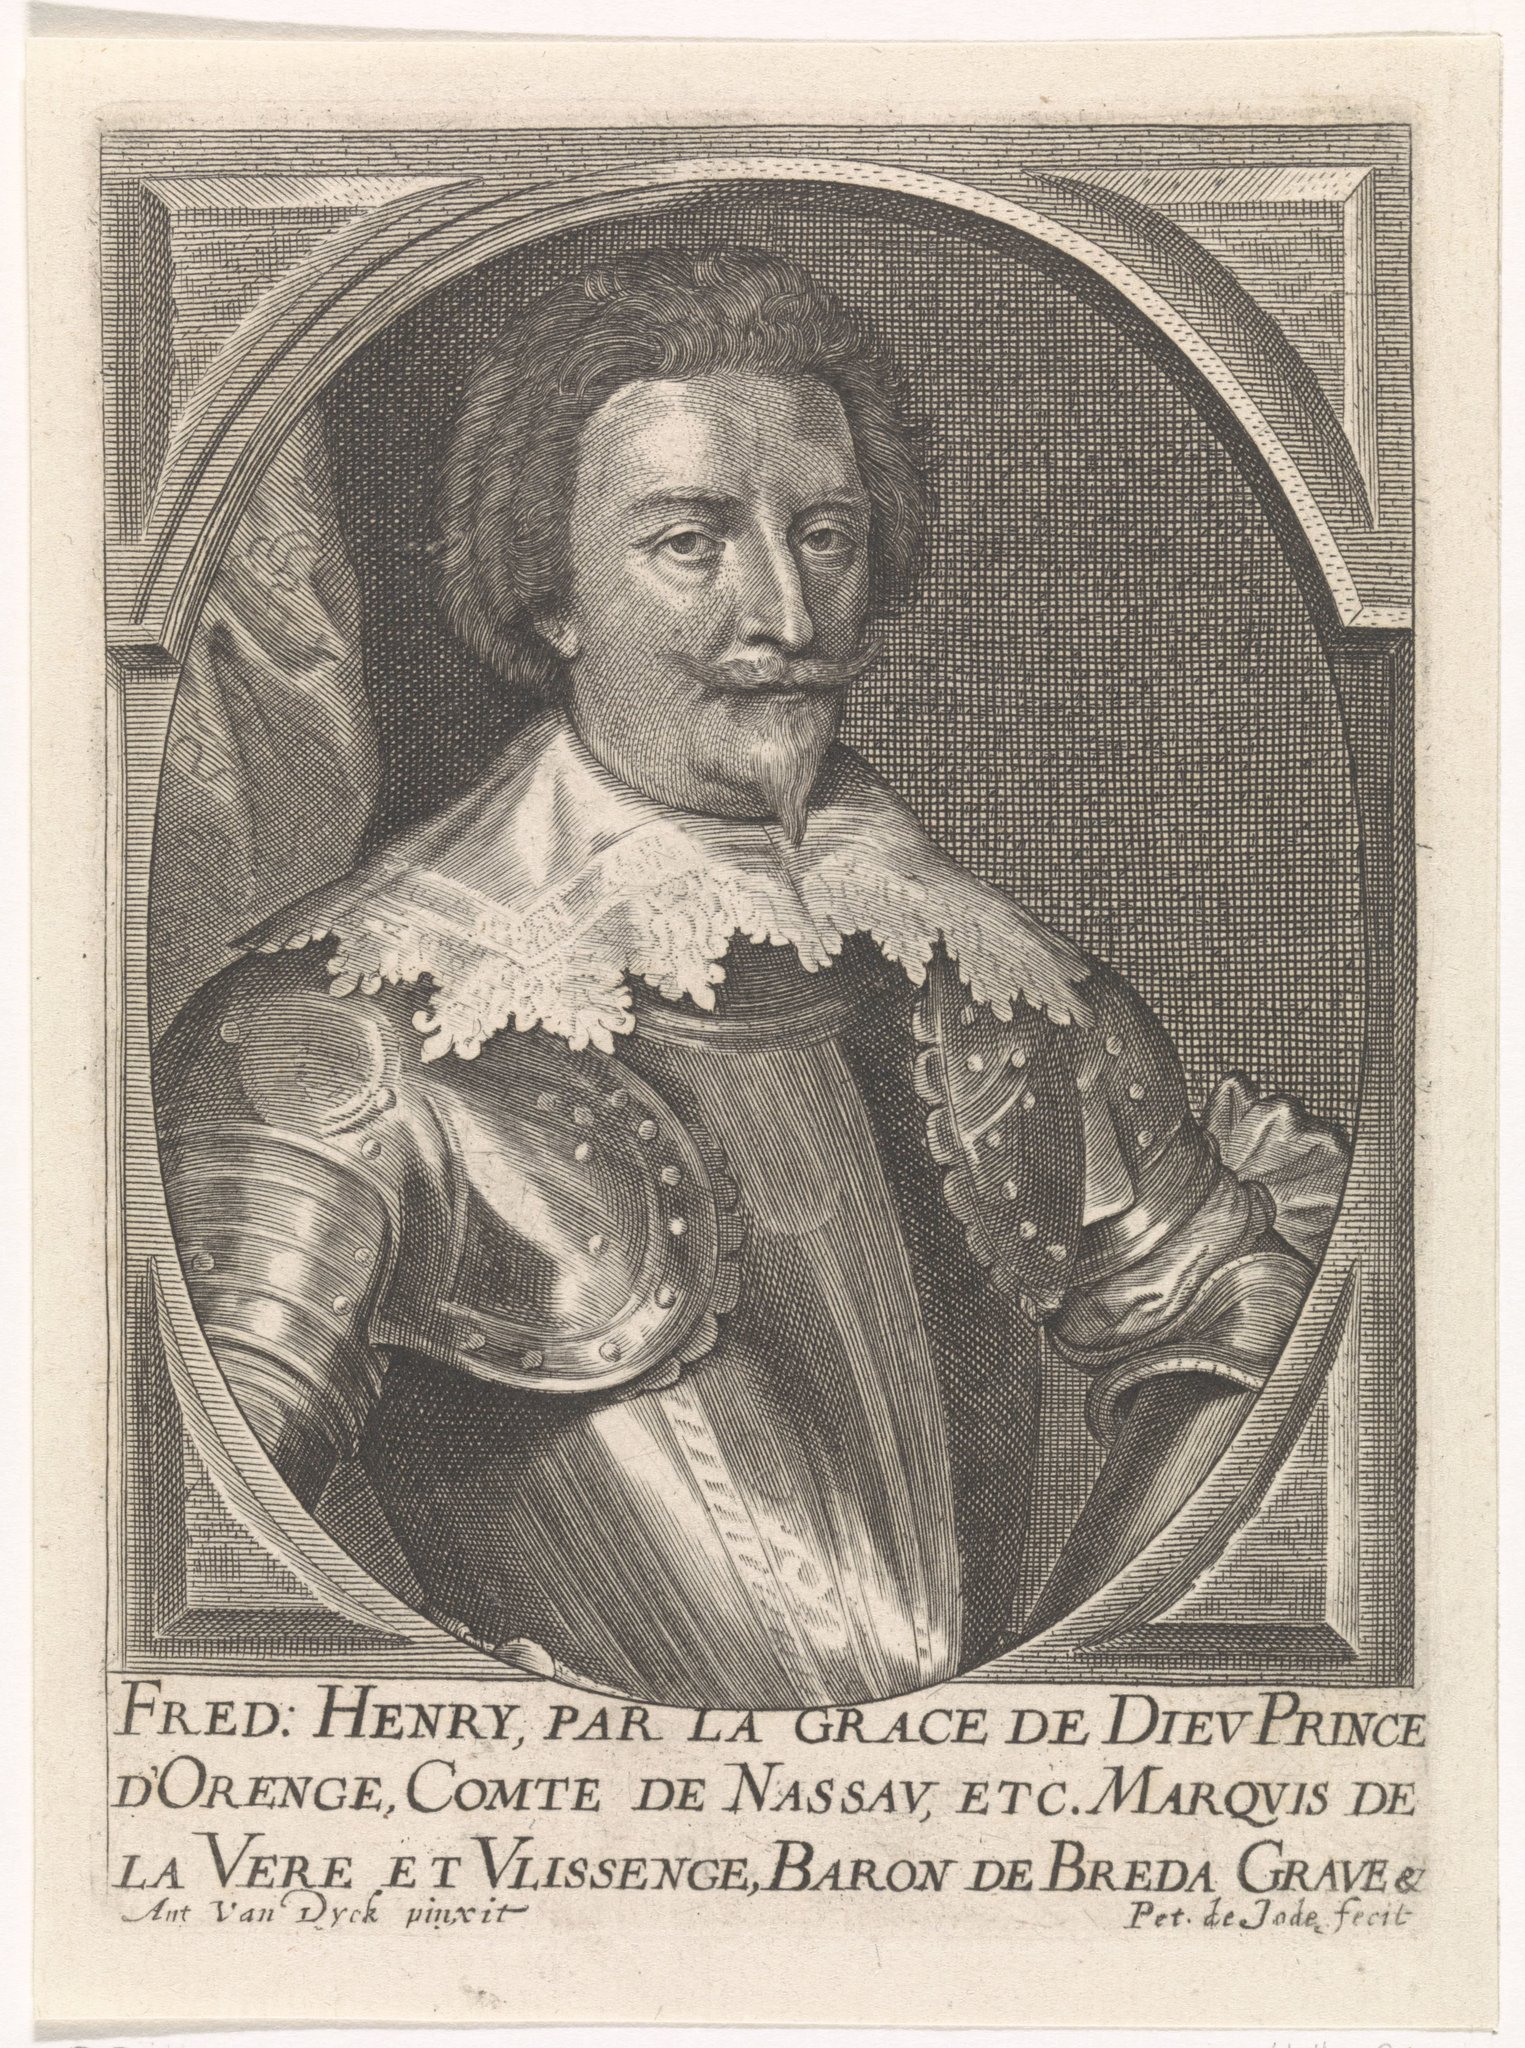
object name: print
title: Portret van Frederik Hendrik, prins van Oranje-Nassau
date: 1628-1670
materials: paper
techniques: engraving, etching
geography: antwerp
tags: delft, frederick henry (prince of orange)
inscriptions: collector's mark: Lugt 2228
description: Busteportret van Frederik Hendrik, in harnas. Het portret is gevat in een ovale omlijsting met vierkant randwerk. In de marge een drieregelig onderschrift in het Frans.